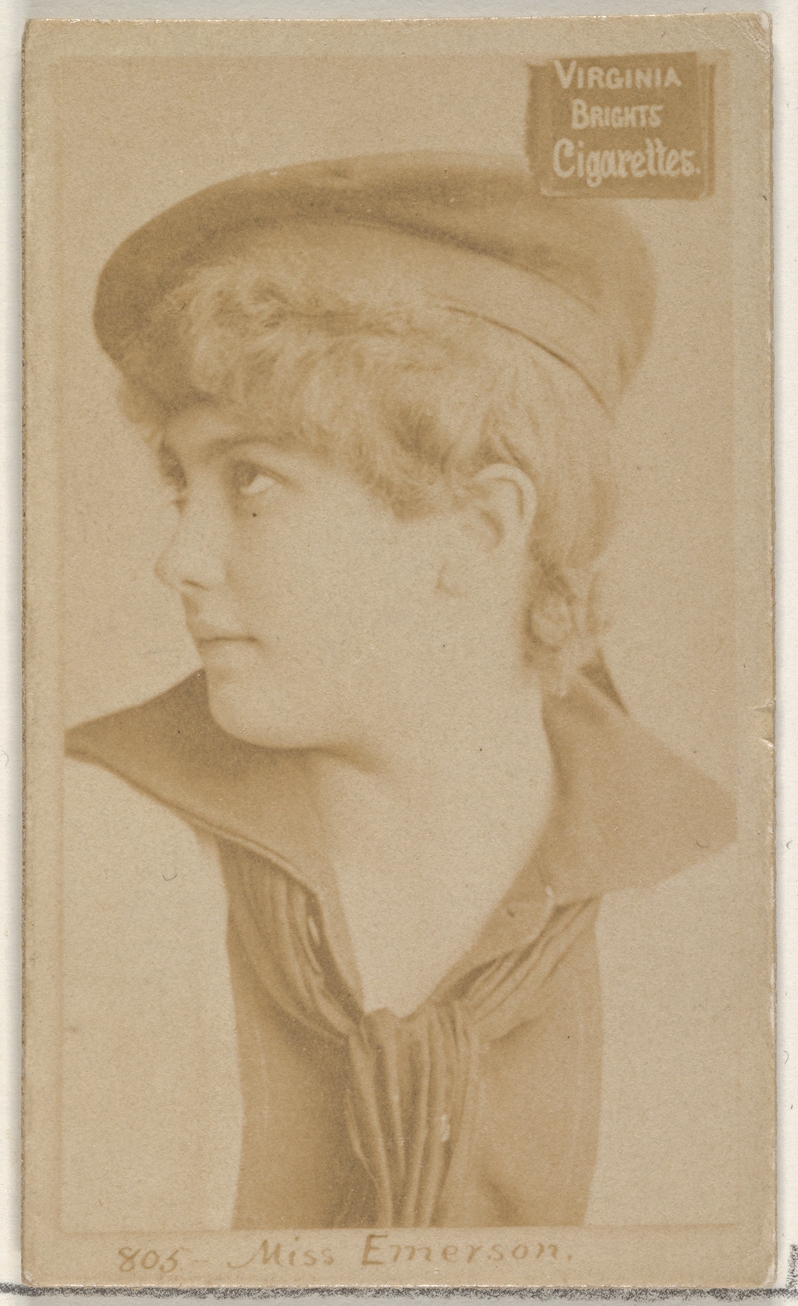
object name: photograph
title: Card 805, Miss Emerson, from the Actors and Actresses series (N45, Type 2) for Virginia Brights Cigarettes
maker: allen & ginter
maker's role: publisher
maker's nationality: american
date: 1888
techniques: albumen silver print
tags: portraits,women,actresses